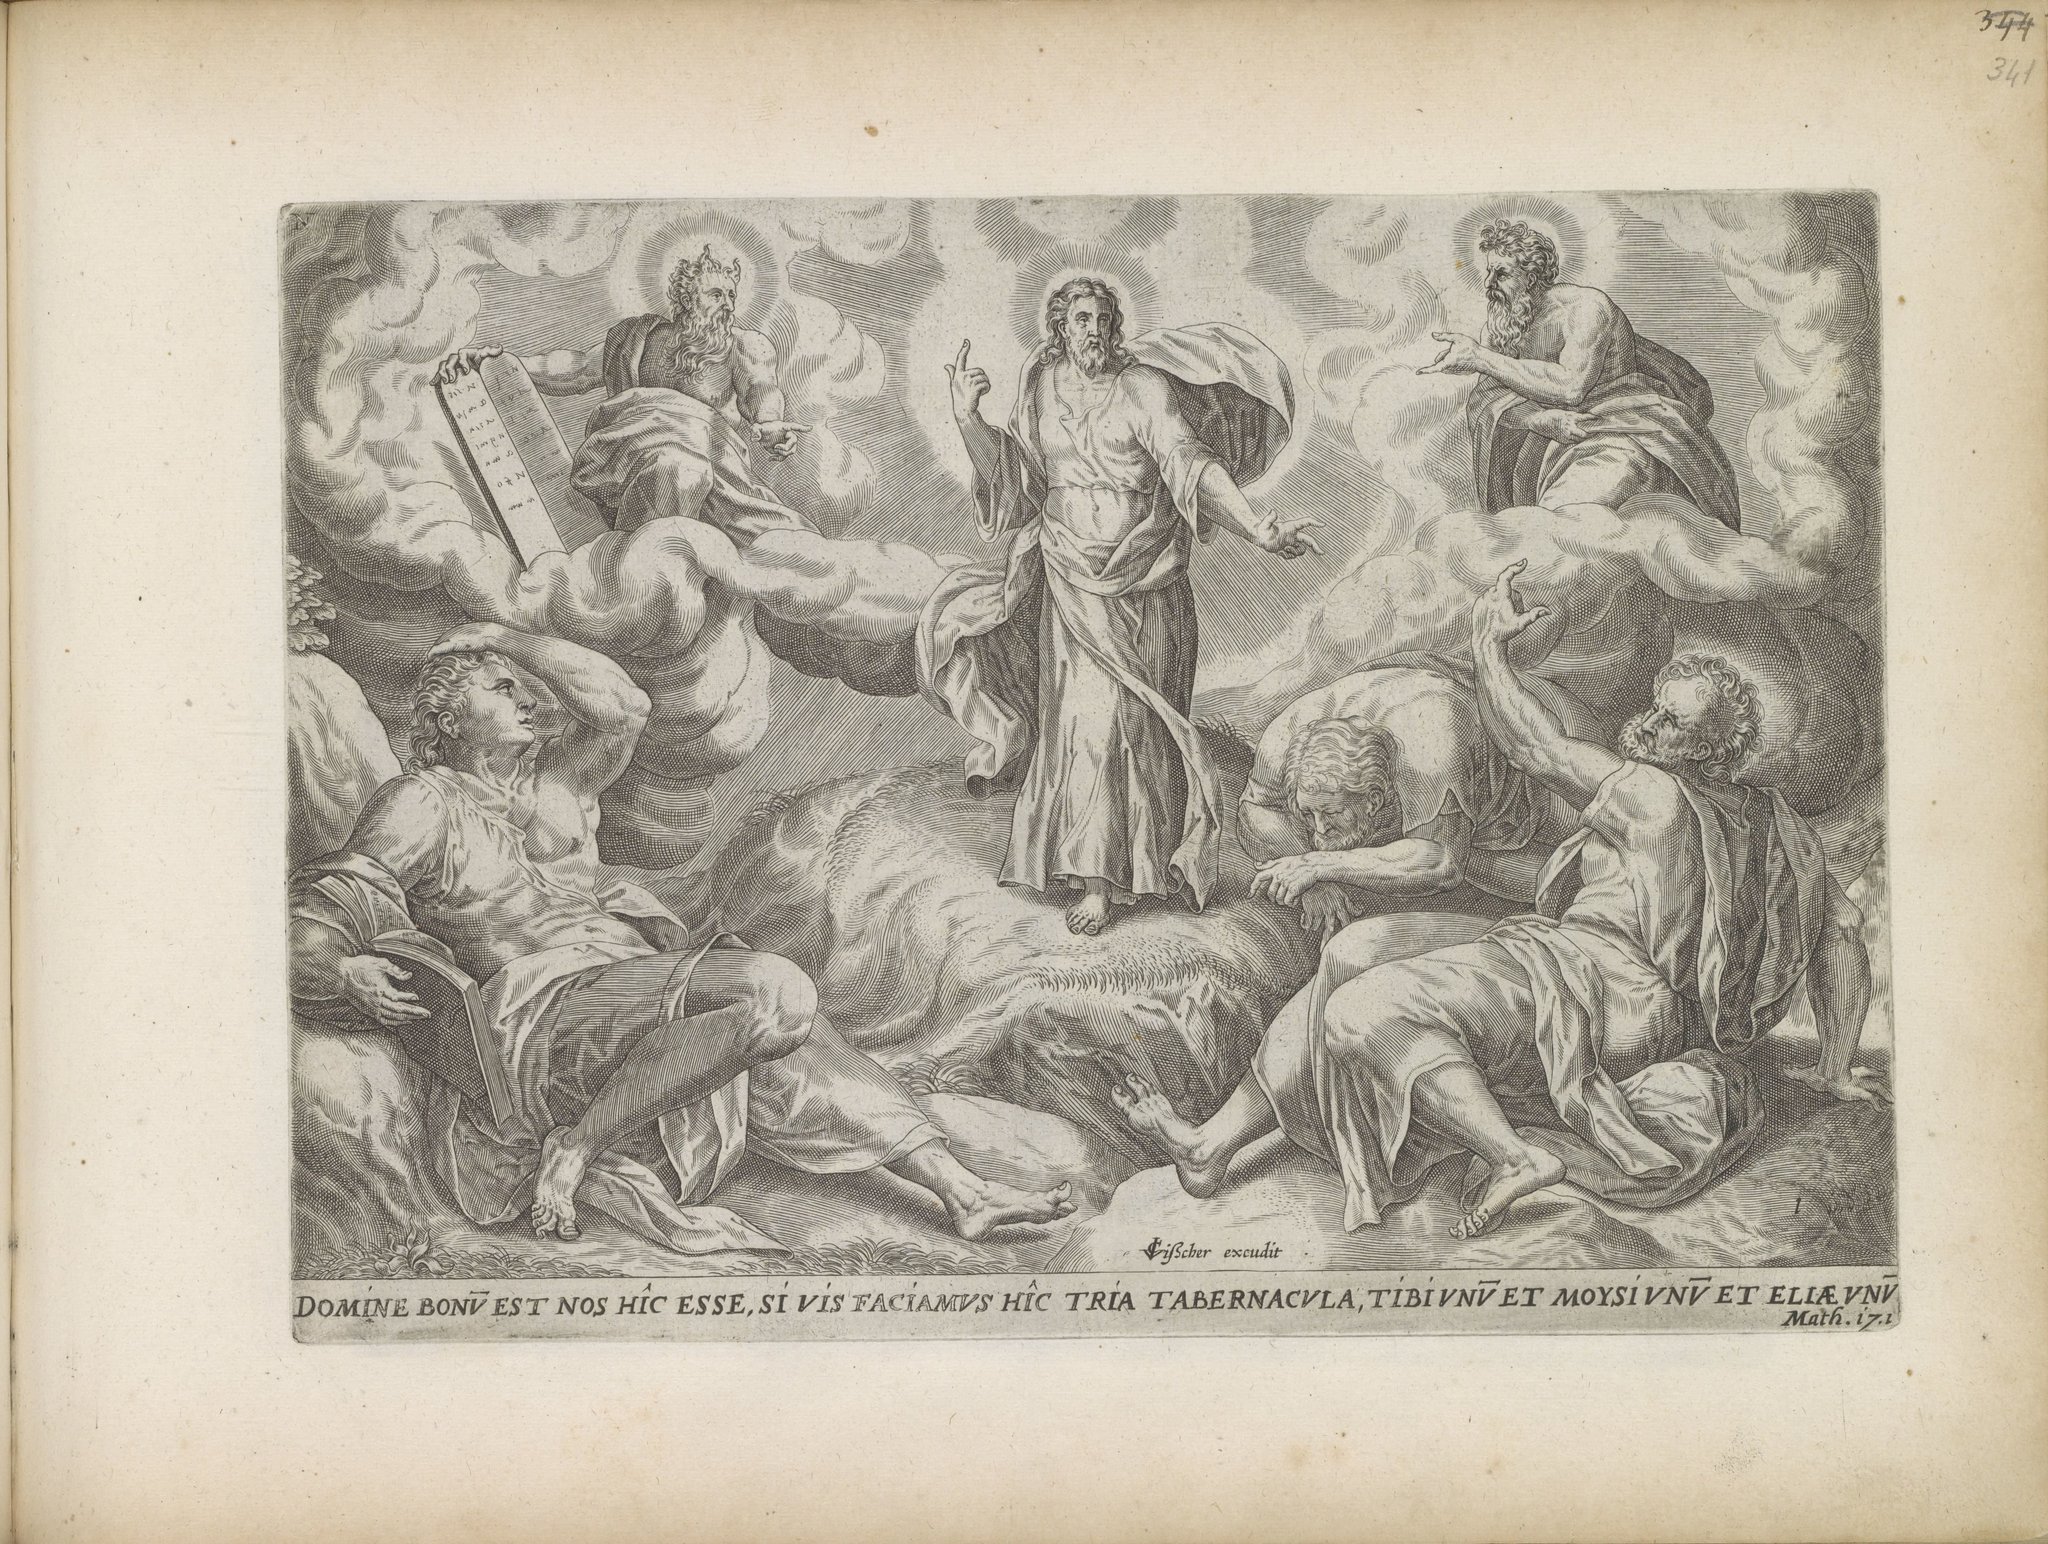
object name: print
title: Transfiguratie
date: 1585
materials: paper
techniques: engraving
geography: amsterdam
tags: 'let us make three booths (tabernacles) ...' ~ the transfiguration, the transfiguration: moses and elijah appear on either side of christ on mount tabor (matthew 17:1-13; mark 9:2-13; luke 9:28-36)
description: De verheerlijking op de berg. Mozes en Elia verschijnen aan weerszijden van Christus en spreken met hem. Op de berg zitten Jakobus, Johannes en Petrus. De laatste maakt een spreekgebaar en doet het voorstel om voor Christus, Mozes en Elia drie tenten neer te zetten. Onder de voorstelling een verwijzing in het Latijn naar de Bijbeltekst in Mat. 17:1. Deze prent maakt deel uit van een album.